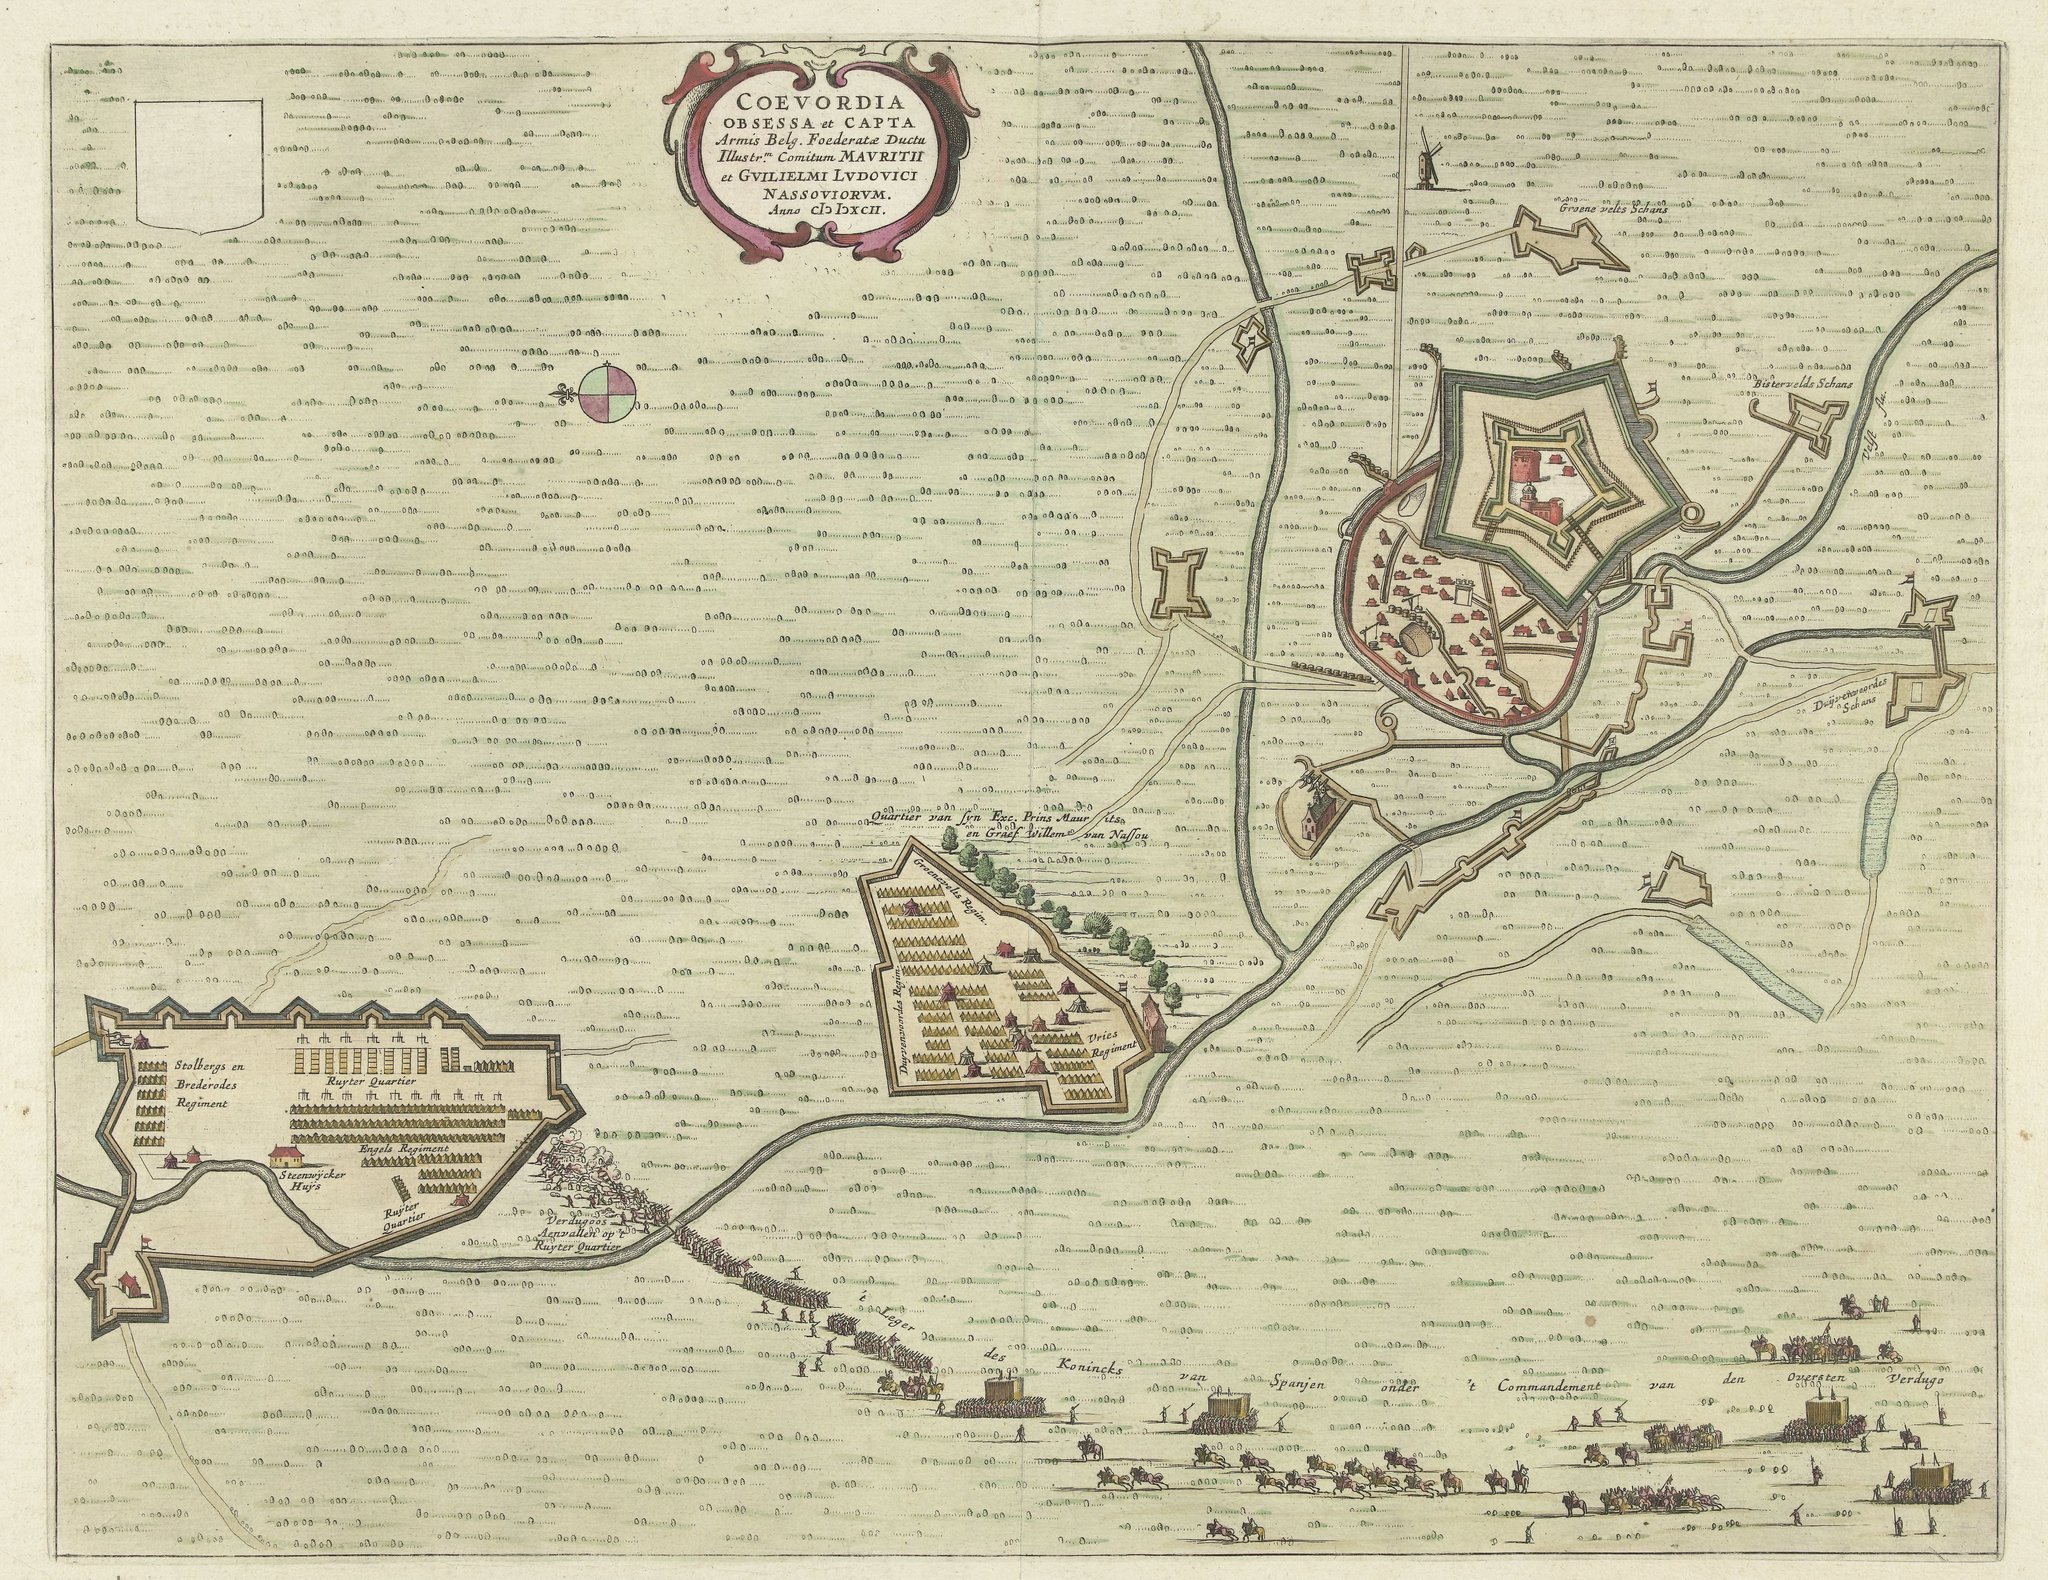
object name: map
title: Kaart van het belegerde Coevorden, 1592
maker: Anonymous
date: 1647-1649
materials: paper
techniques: etching, hand coloring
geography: northern netherlands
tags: the hague, maurice (prince of orange), siege, position war, maps of cities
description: Beleg van Coevorden door het Staatse leger onder Maurits en Willem Lodewijk, juli - september 1592. Plan van de vesting met het kasteel Coevorden met het omringende land met de posities van de belegerende troepen. Onderaan trekt het Spaanse leger onder Verdugo op naar het ruiterkwartier. Op een dubbelblad uit het het Stedenboek van Blaeu genomen, op beide zijden bedrukt met tekst in het Nederlands.